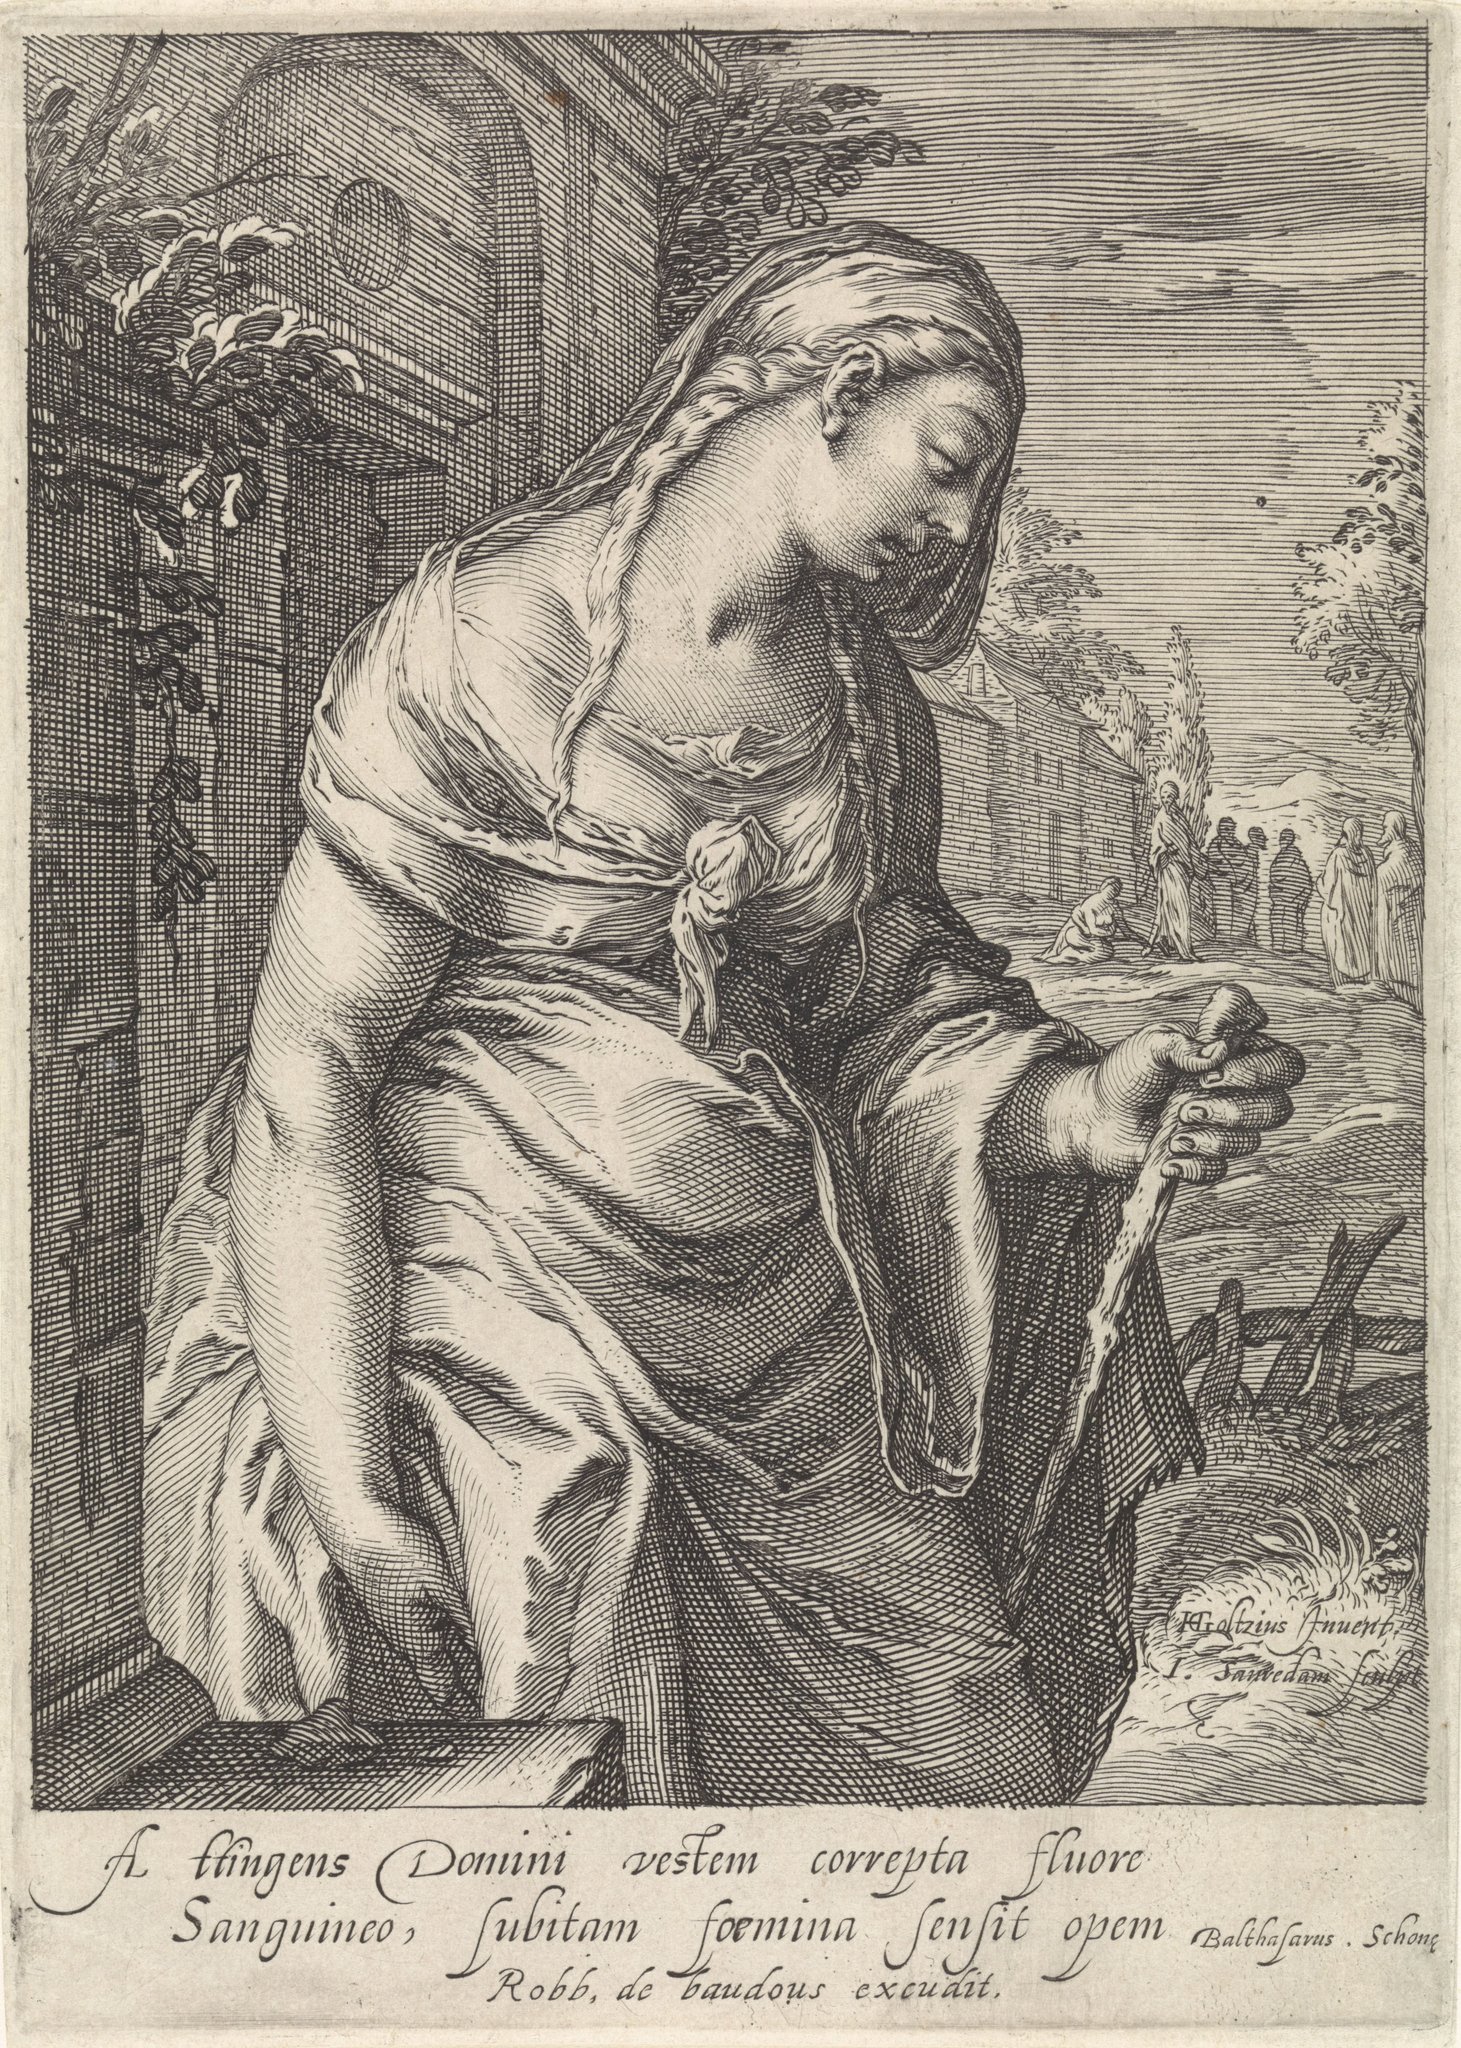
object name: print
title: Beroemde vrouwen uit het Nieuwe Testament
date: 1584-1659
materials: paper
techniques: engraving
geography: northern netherlands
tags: healing of a woman with an issue of blood: she kneels before christ after having touched his robe (matthew 9:20-22; mark 5:25-34; luke 8:43-48)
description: De vrouw die aan bloedvloeiingen leed. Ze loopt gebukt met een wandelstok. Op de achtergrond geneest Christus de vrouw. De prent heeft een Latijns onderschrift en maakt deel uit van een prentserie met beroemde vrouwen uit het Nieuwe Testament.